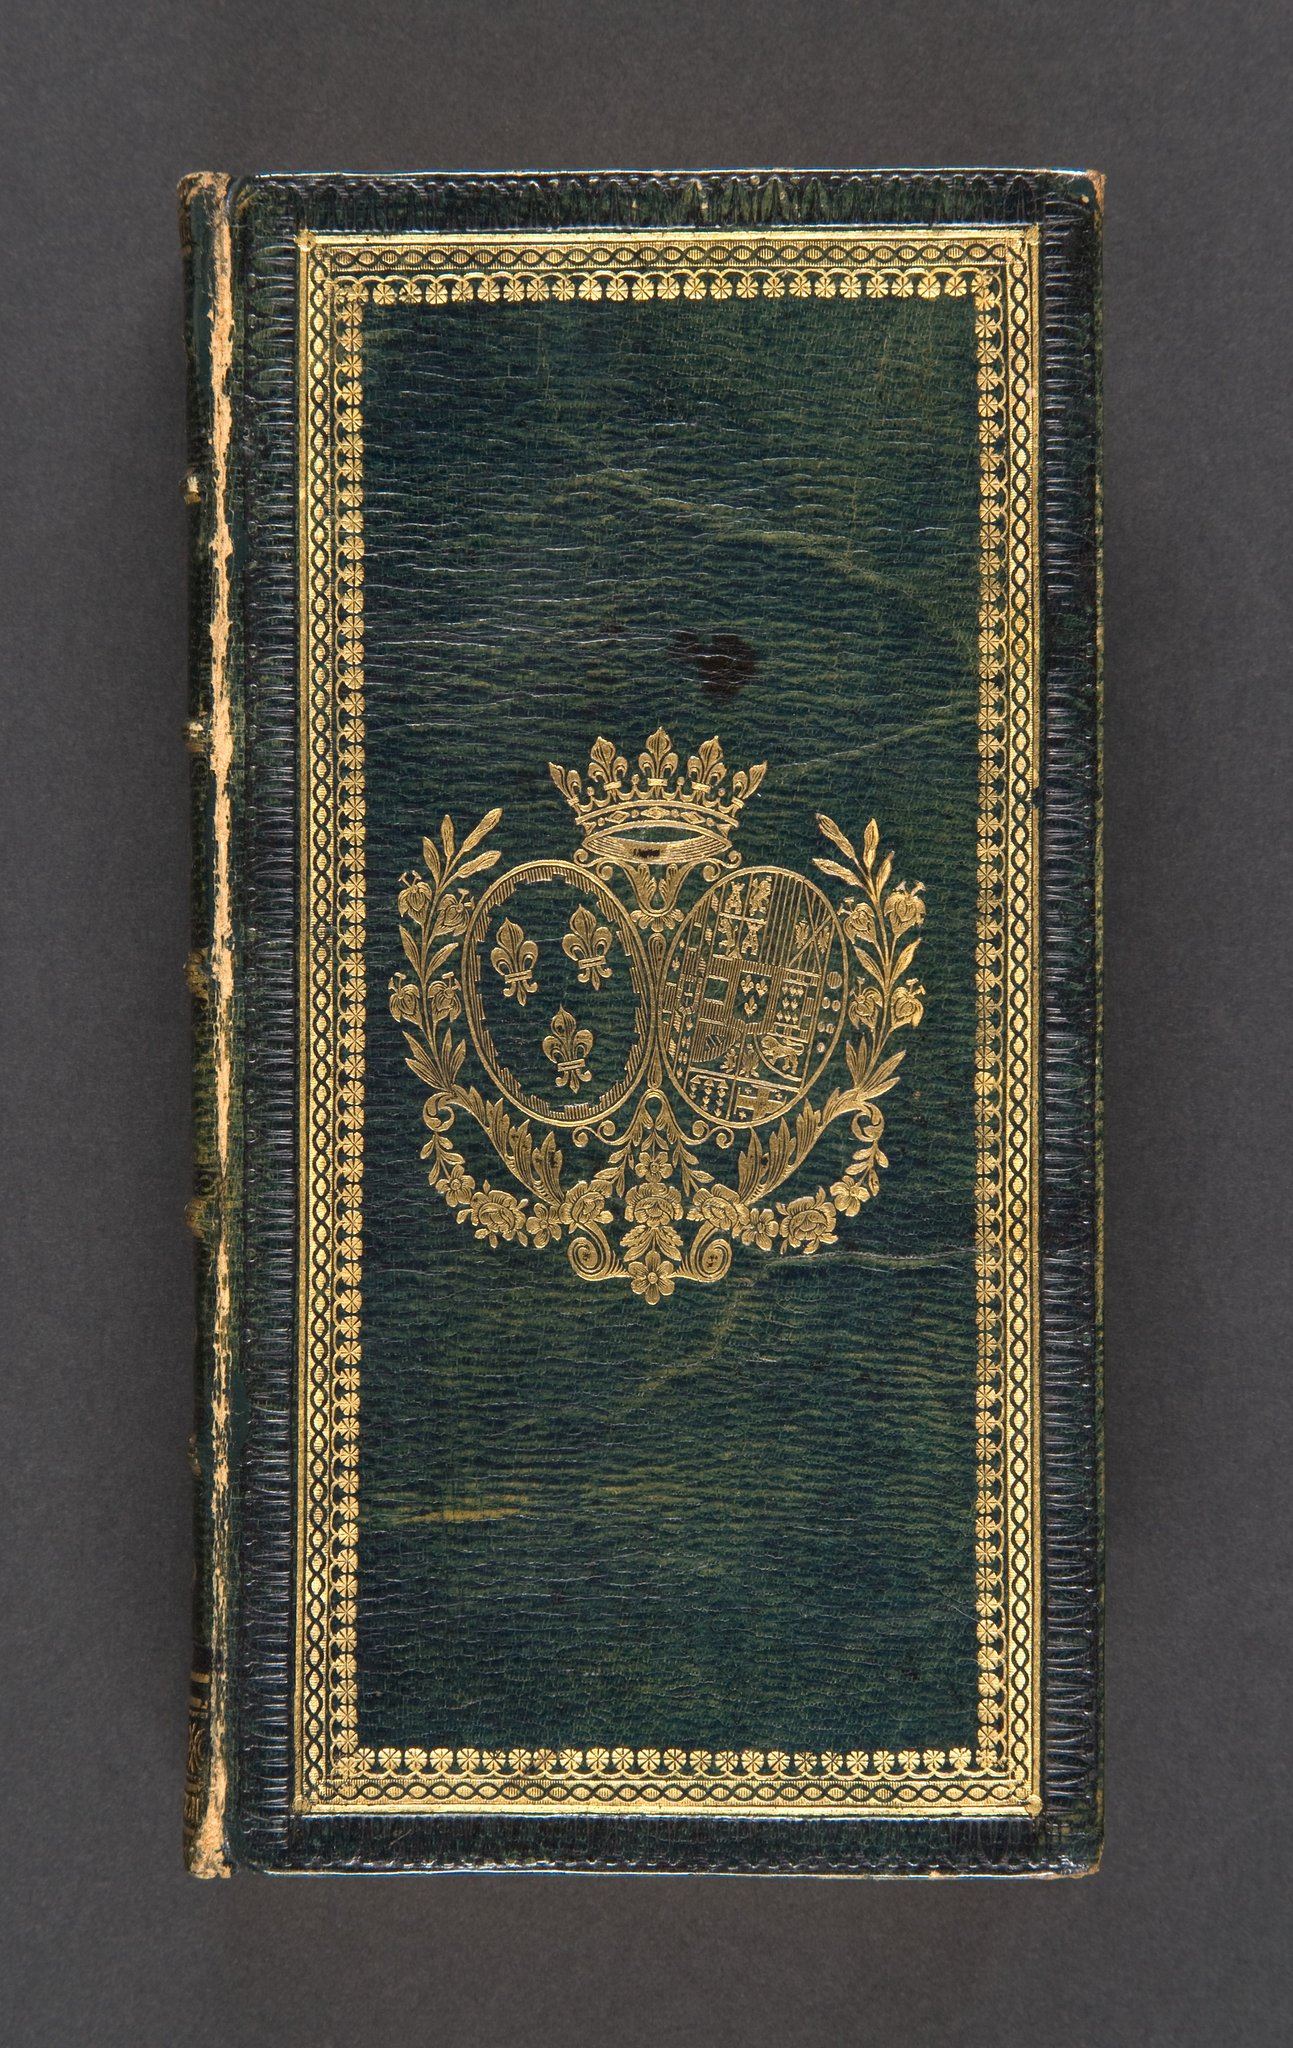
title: De' ragguagli di Parnaso: Centuria prima-seconda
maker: johannes blaeu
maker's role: printer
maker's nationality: dutch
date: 1669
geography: netherlands